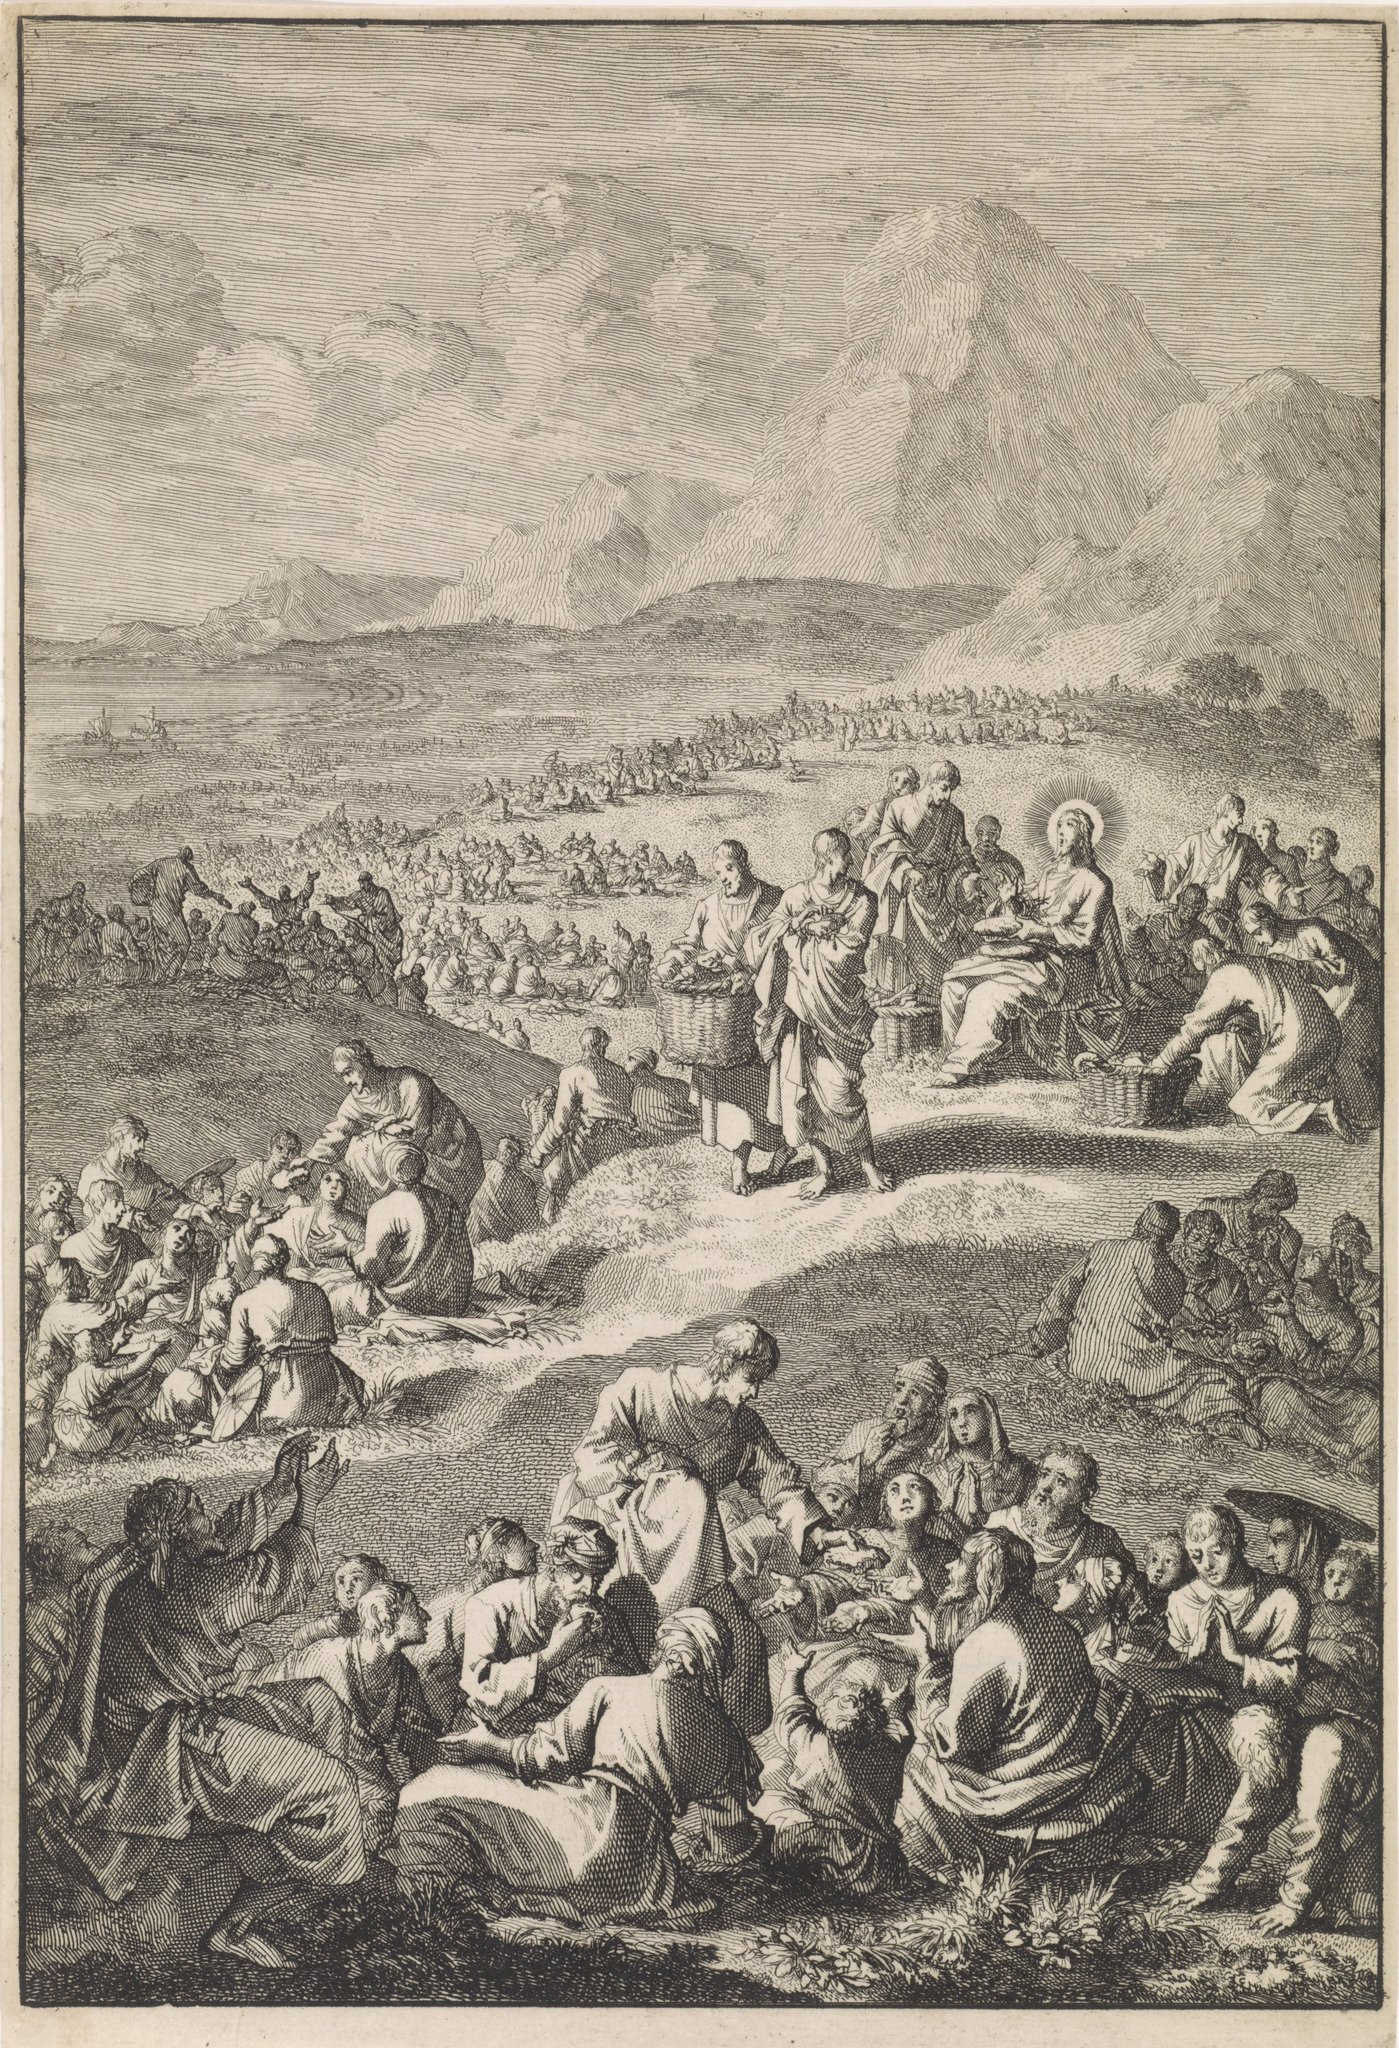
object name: print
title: Wonderbaarlijke vermenigvuldiging van de zeven broden en de twee vissen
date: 1700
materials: paper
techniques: etching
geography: amsterdam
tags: christ and apostles distribute bread and fish among the multitude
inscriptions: collector's mark: Lugt 2228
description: Proefdruk van een boekillustratie voor Jeremy Taylor. Historie van't leven en de doot van onsen saligmaker Jesus Christus. Deel III. Amsterdam: Willem Broedelet, 1700, p. 53.